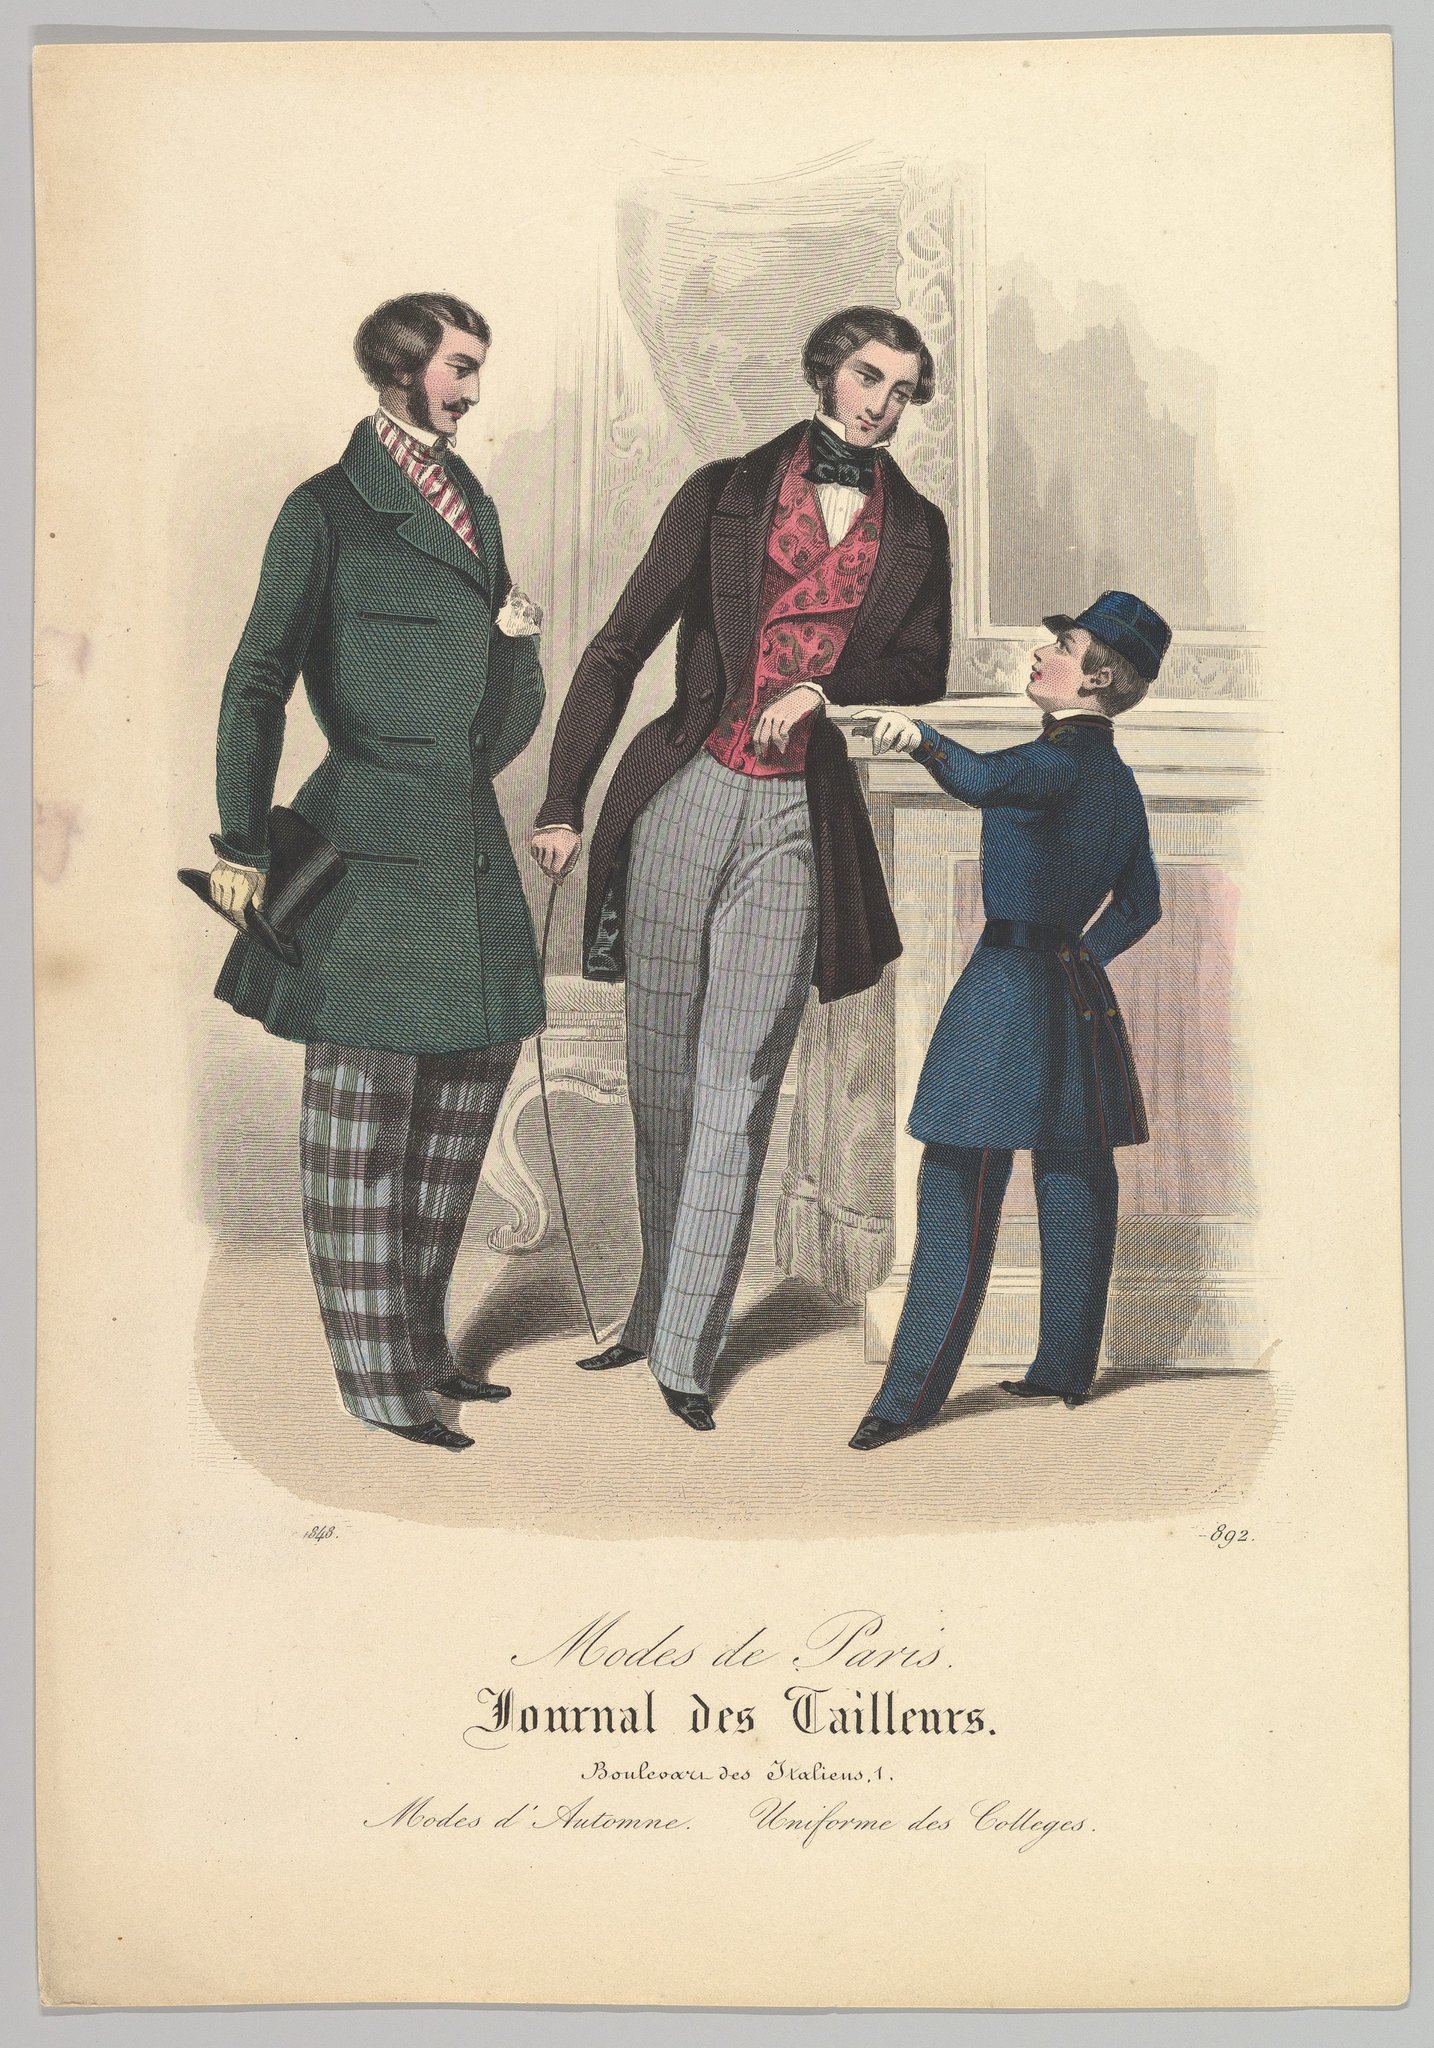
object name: print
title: 892 from Modes de Paris, Journal des Tailleurs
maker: anonymous, french, 19th century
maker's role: artist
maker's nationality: french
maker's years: 1800-1900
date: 1848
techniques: hand coloring, lithograph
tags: boys,men,fashion